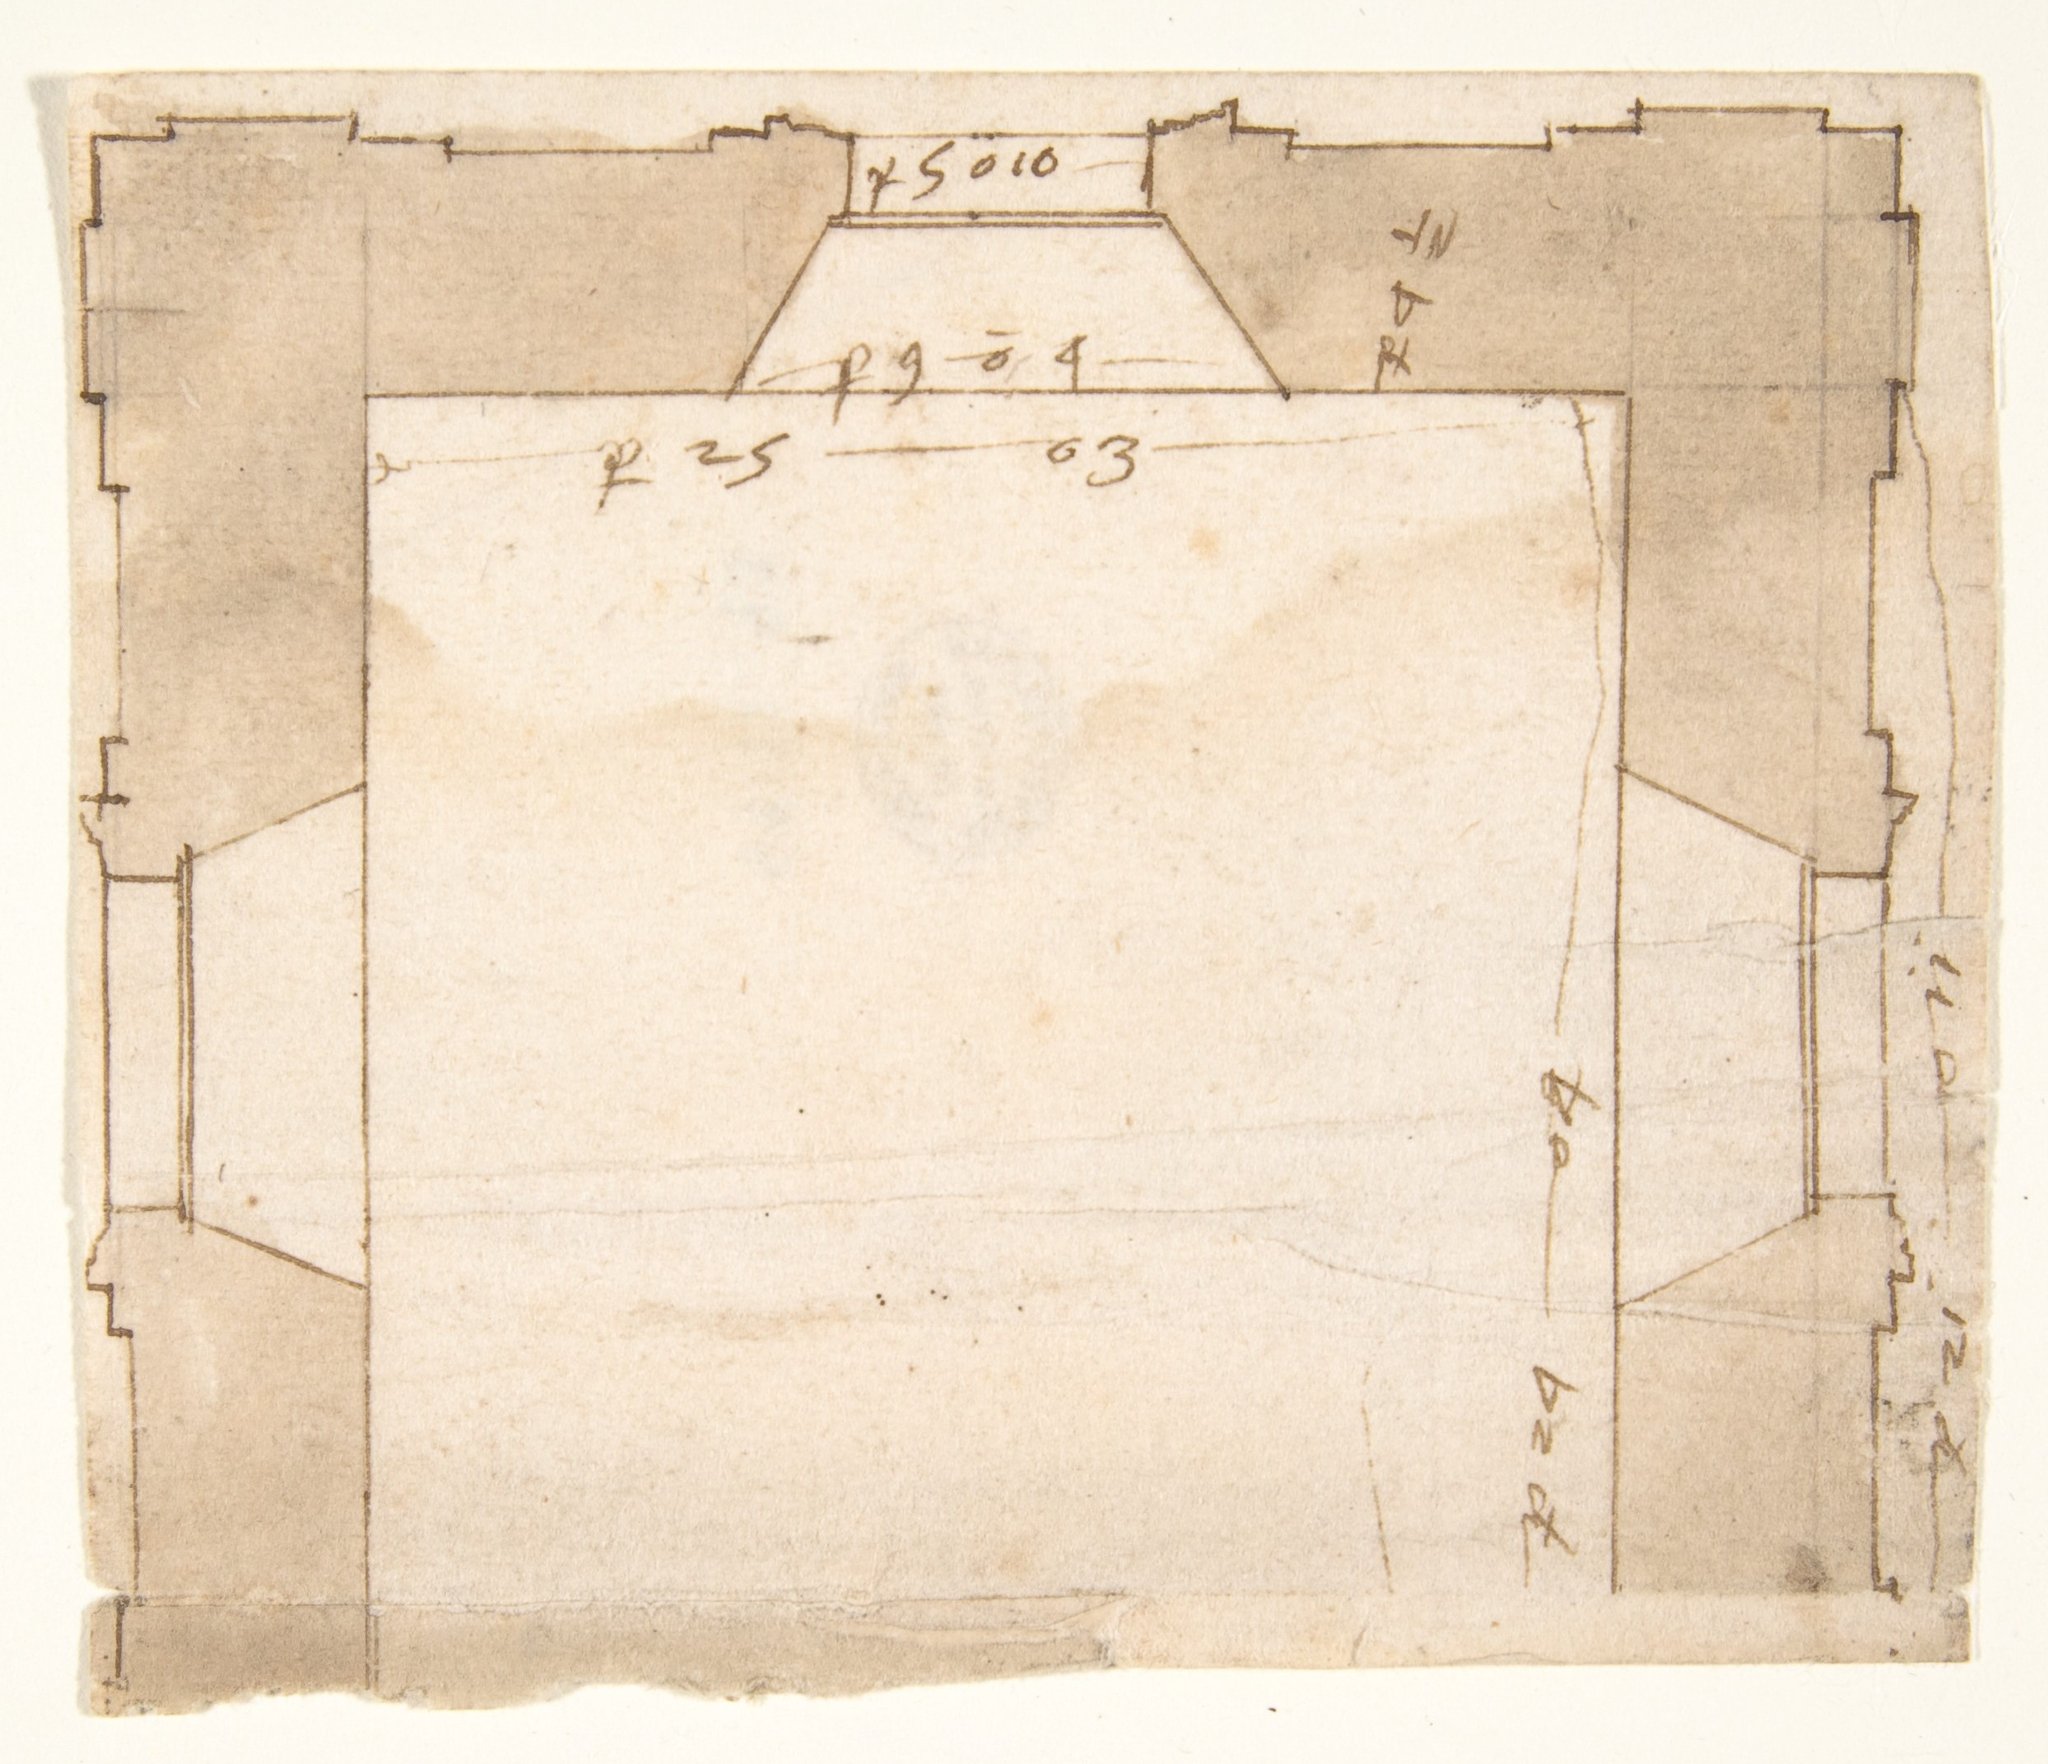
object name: drawing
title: Unidentified, plan (recto) blank (verso)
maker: anonymous, french, 16th century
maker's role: draftsman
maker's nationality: french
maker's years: 1500-1600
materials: chalk, ink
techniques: incising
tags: architecture